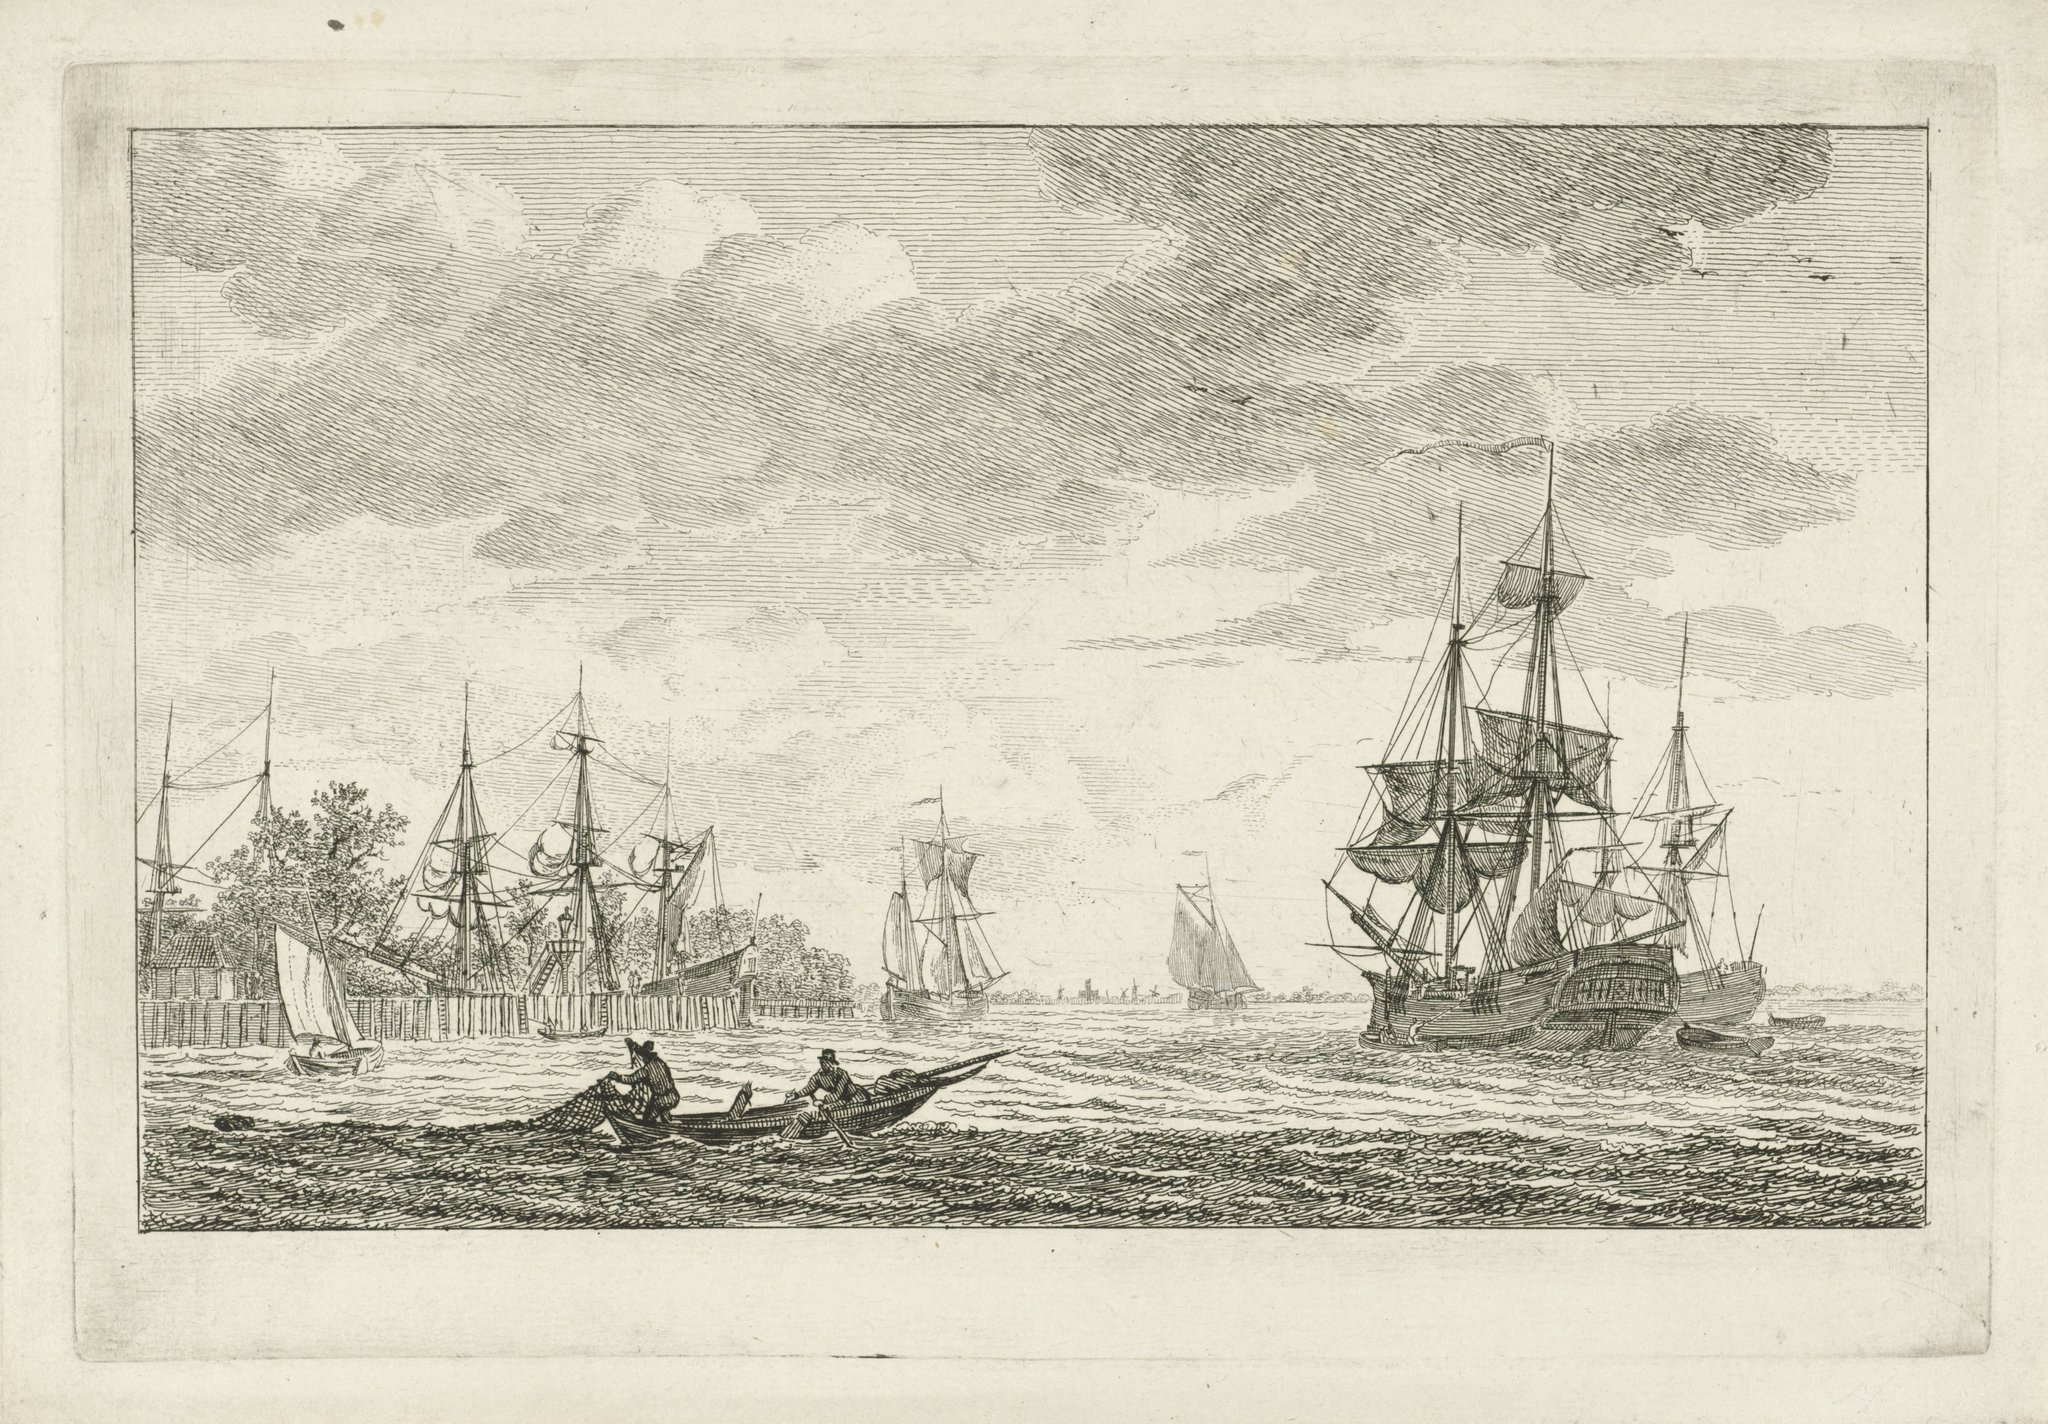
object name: print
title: Gezichten op de Maas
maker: gerrit groenewegen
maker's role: draughtsman, print maker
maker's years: 1754-1826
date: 1797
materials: paper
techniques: etching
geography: rotterdam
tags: harbour, sailing-ship, sailing-boat, rowing-boat, canoe, etc., fisherman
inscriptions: collector's mark: Lugt 2228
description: Gezicht op de Maas en het westelijke havenhoofd van Schiedam (links), waar een schip de haven binnenvaart. Op de voorgrond een kleine vissersboot en zeilschepen. Deze prent maakt deel uit van een serie van zes prenten met Maasgezichten.